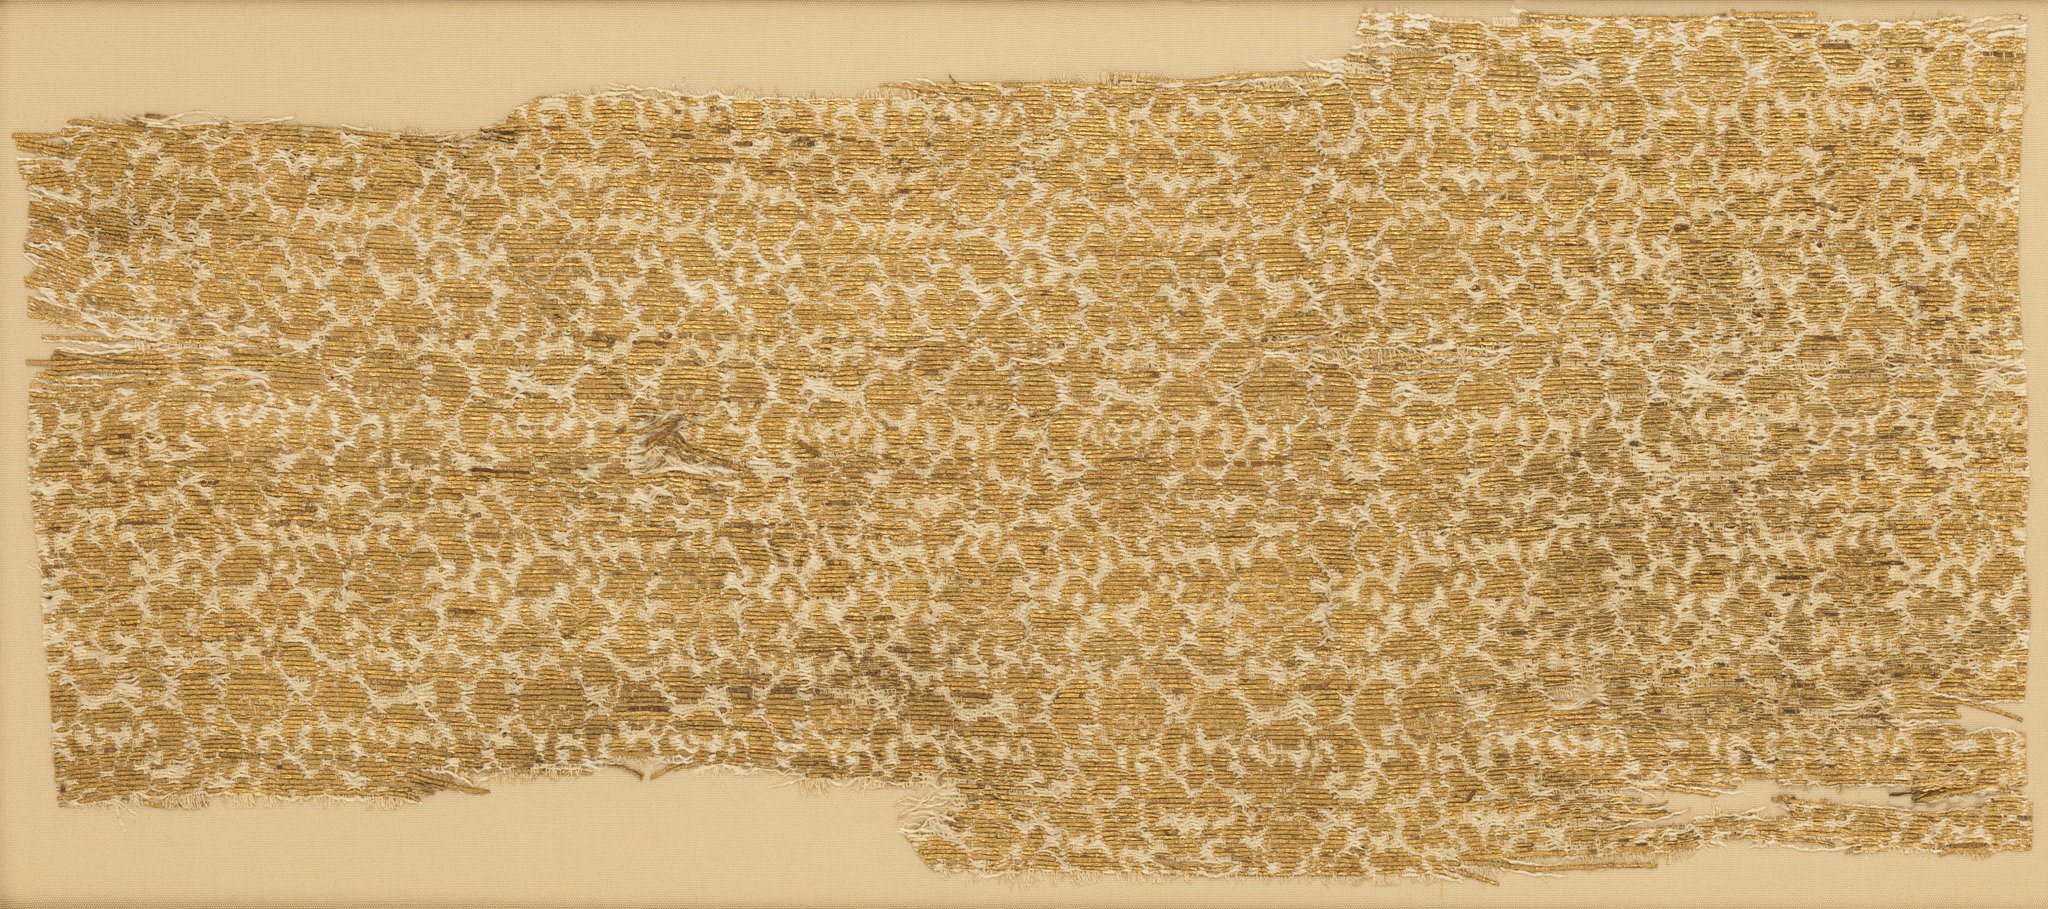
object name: textile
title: Textile with Floral Pattern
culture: chinese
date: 1267-1366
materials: metal thread, silk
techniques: lampas